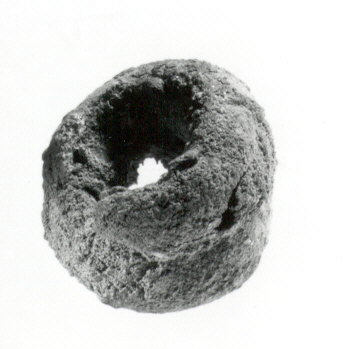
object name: spiral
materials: silver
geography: syria